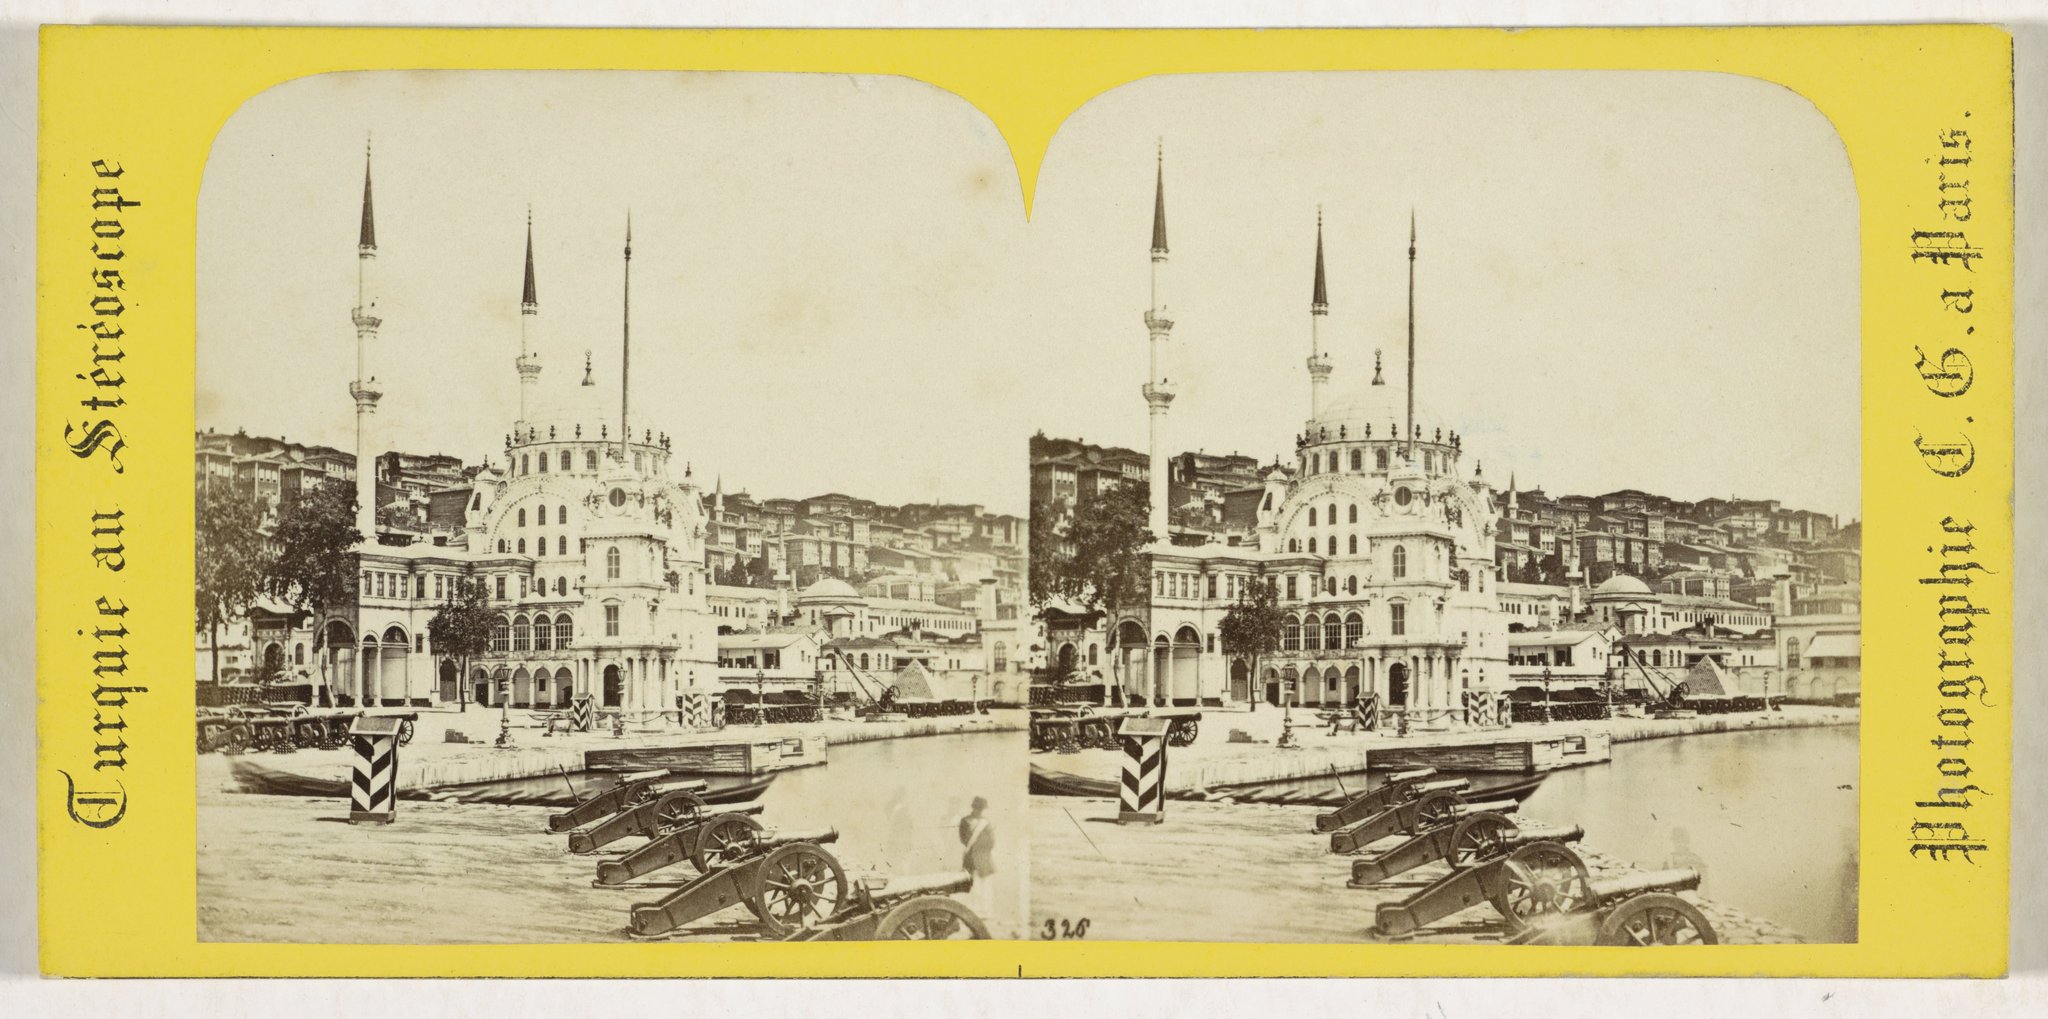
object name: stereograph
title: Nusretiye moskee in Tophane, Istanboel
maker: charles gaudin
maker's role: publisher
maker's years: 1825-1905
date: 1861-1870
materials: cardboard, paper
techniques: albumen print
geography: nusretiye moskee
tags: temple, shrine ~ islam, mohammedanism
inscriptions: number: ‘328’